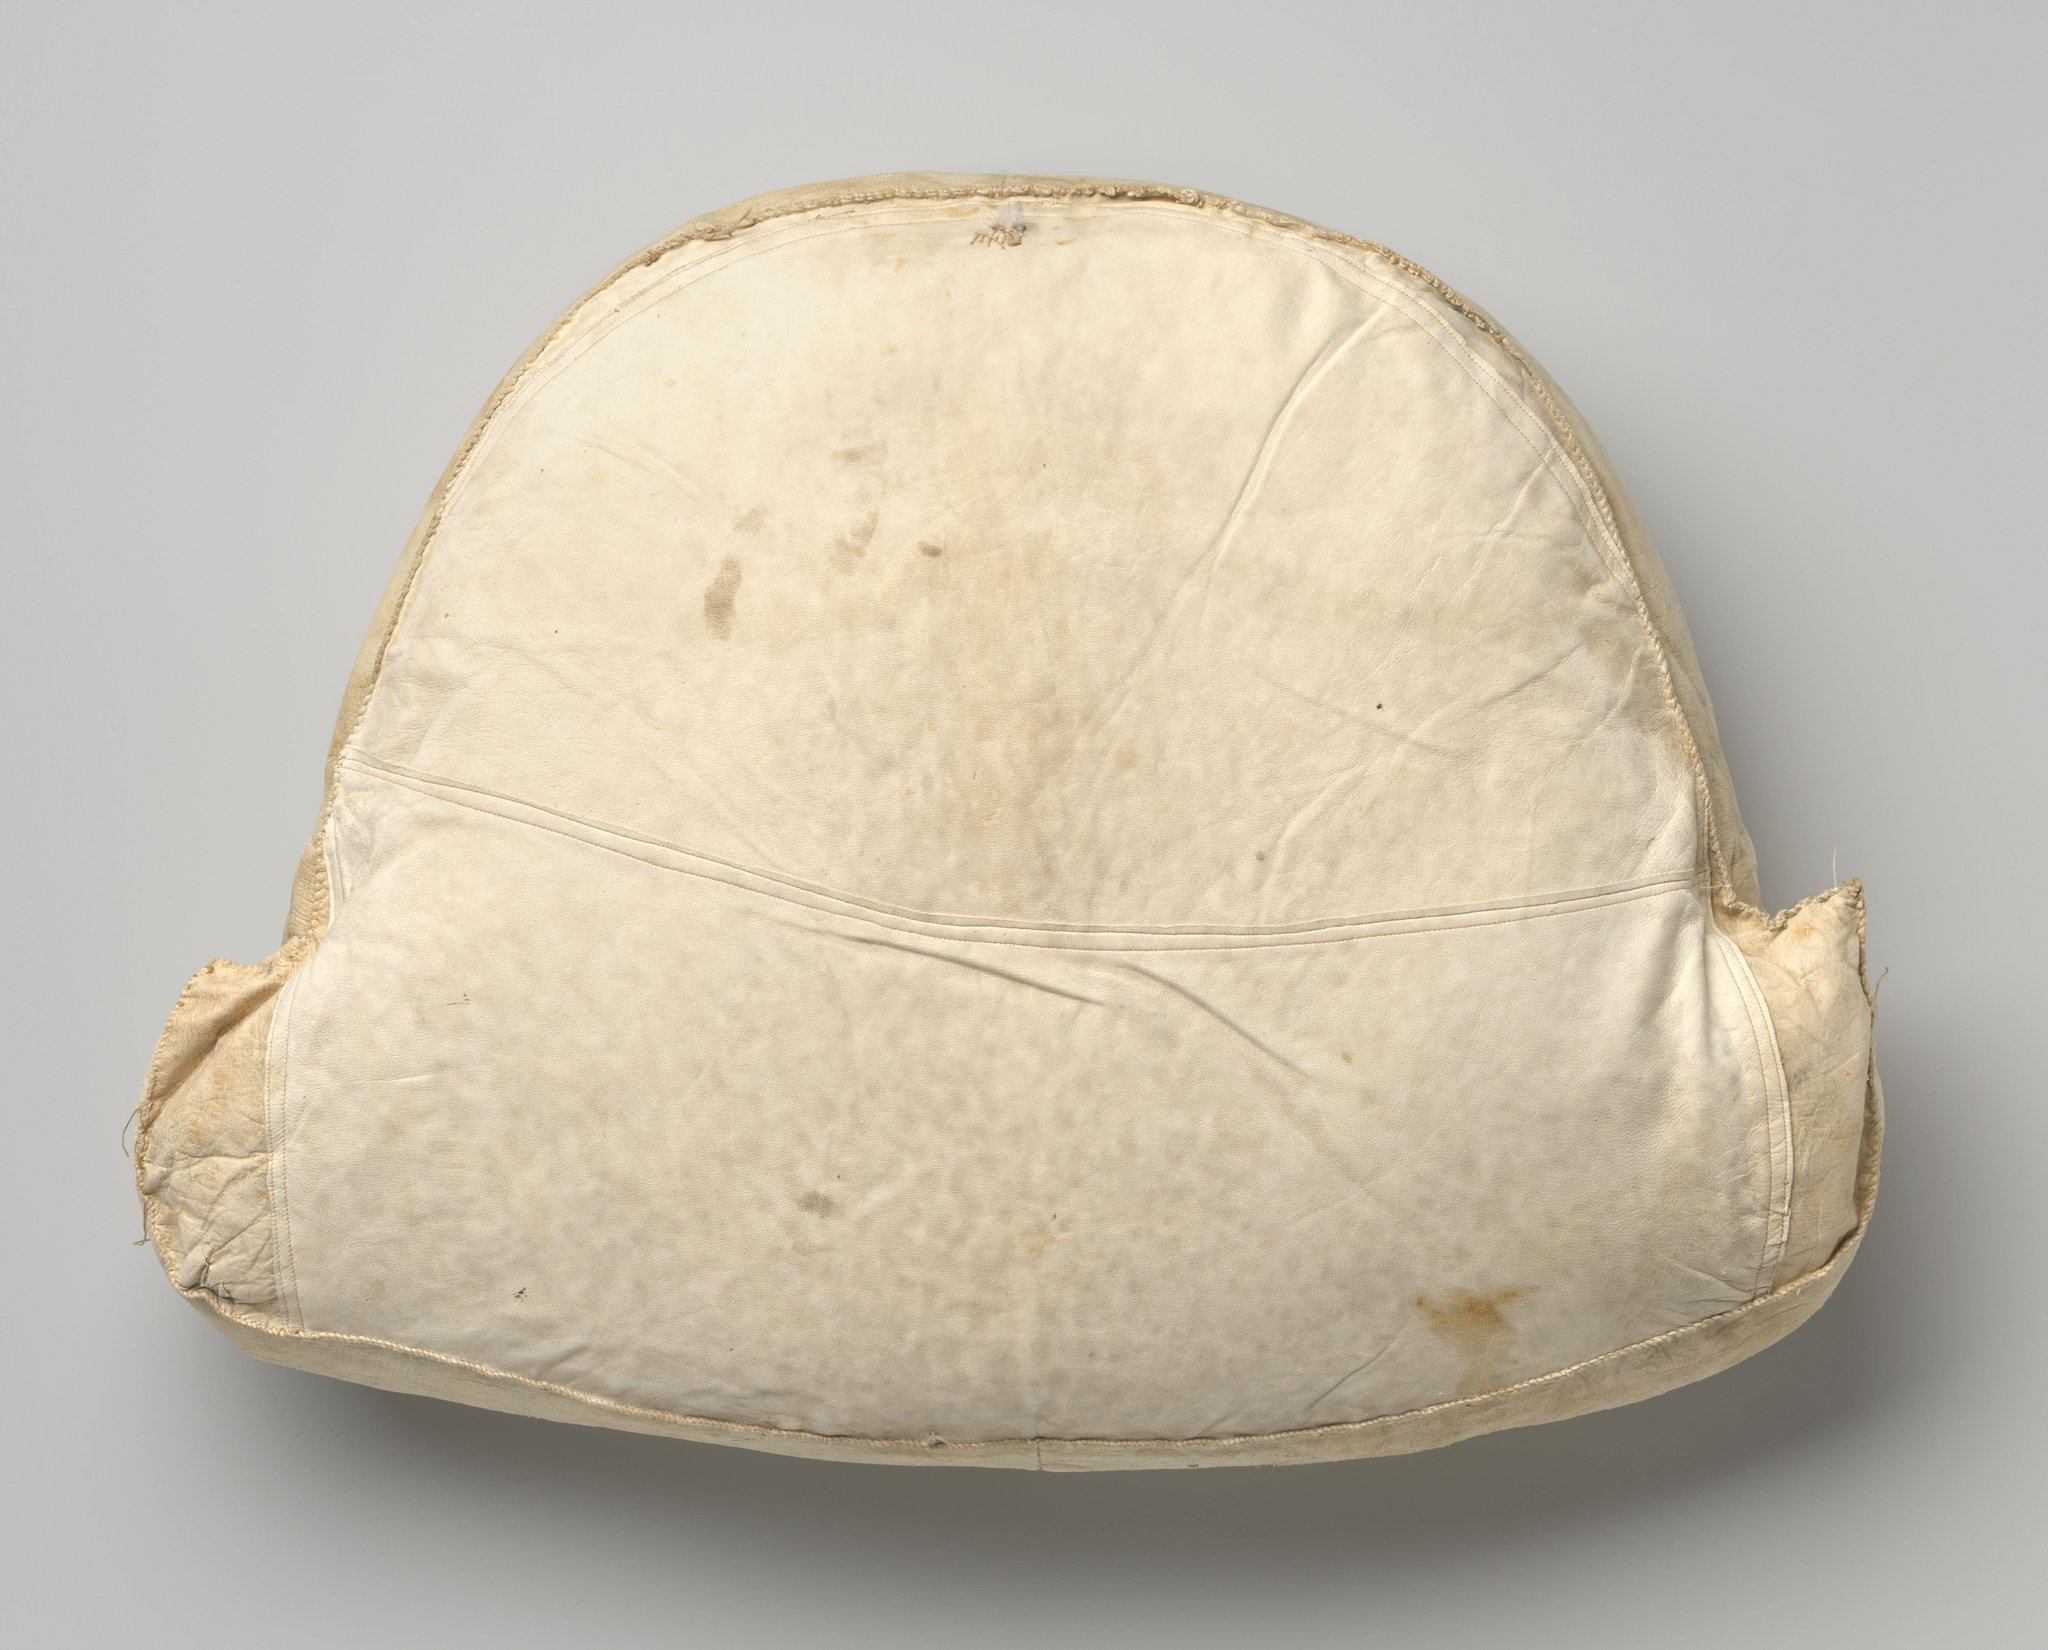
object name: cushion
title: Kussen van bergère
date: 1750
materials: cotton, leather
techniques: embroidered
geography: france